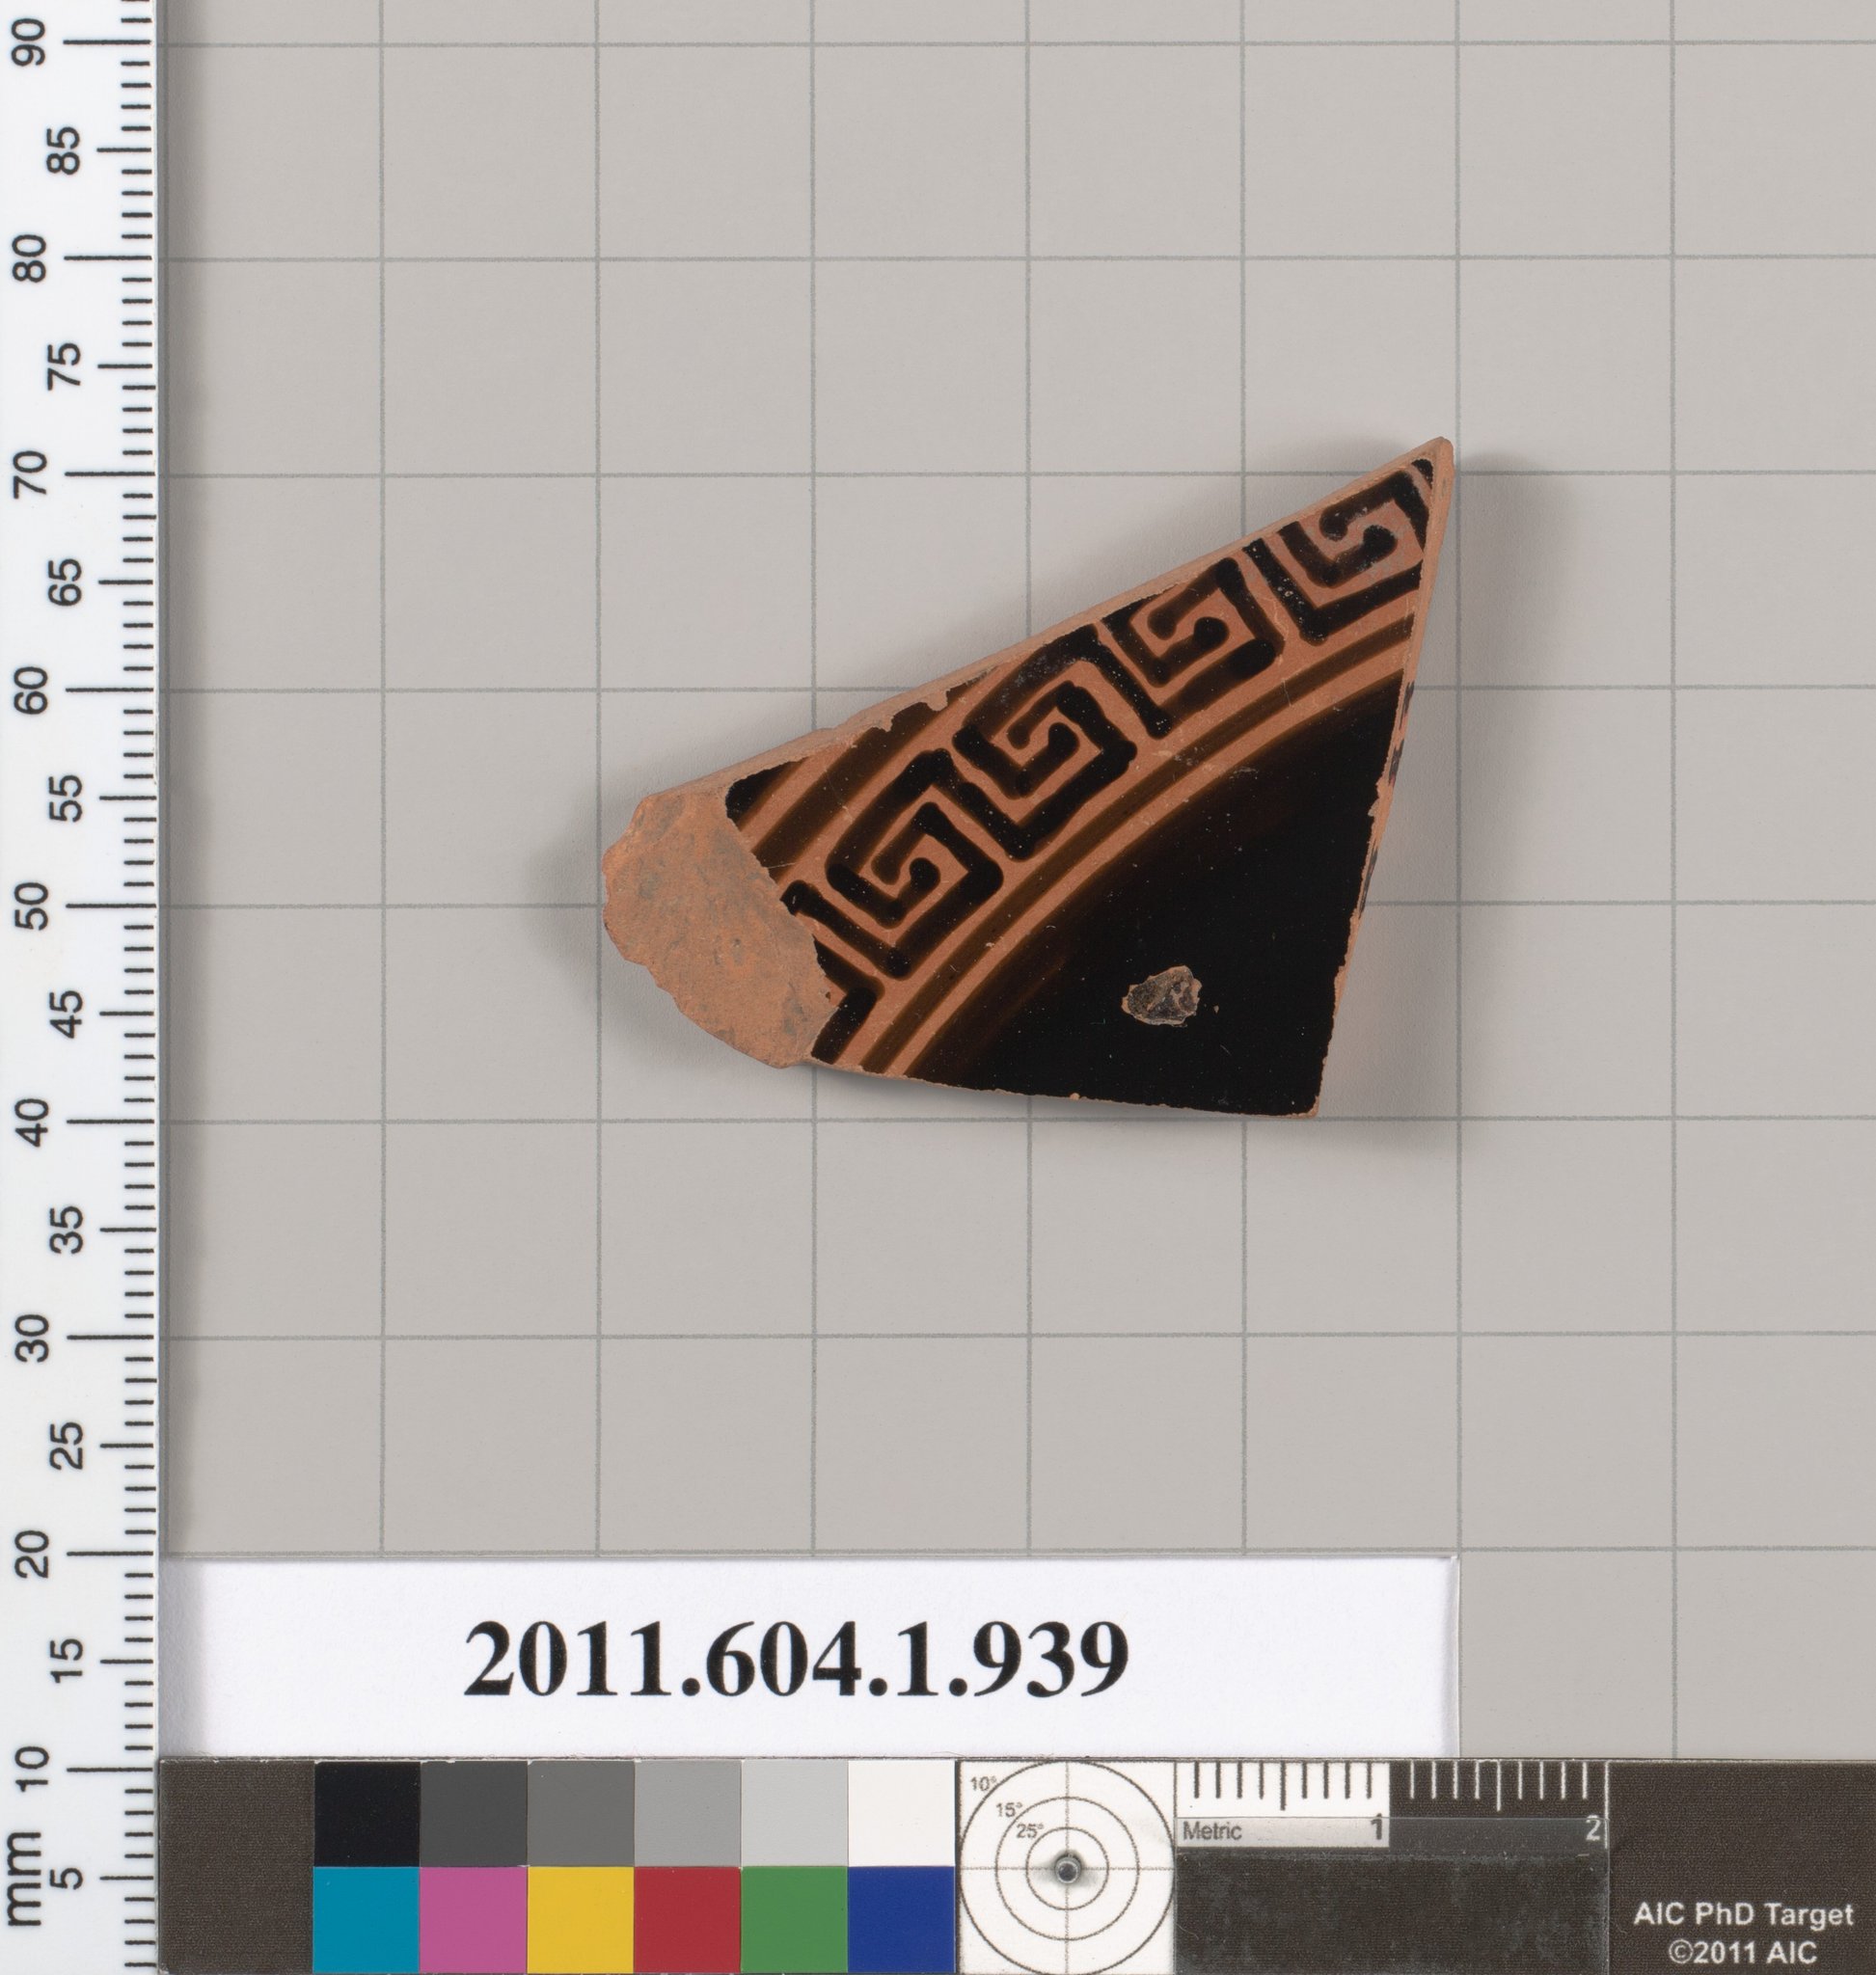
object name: kylix fragment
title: Terracotta fragment of a kylix (drinking cup)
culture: greek, attic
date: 490-480 BCE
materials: terracotta